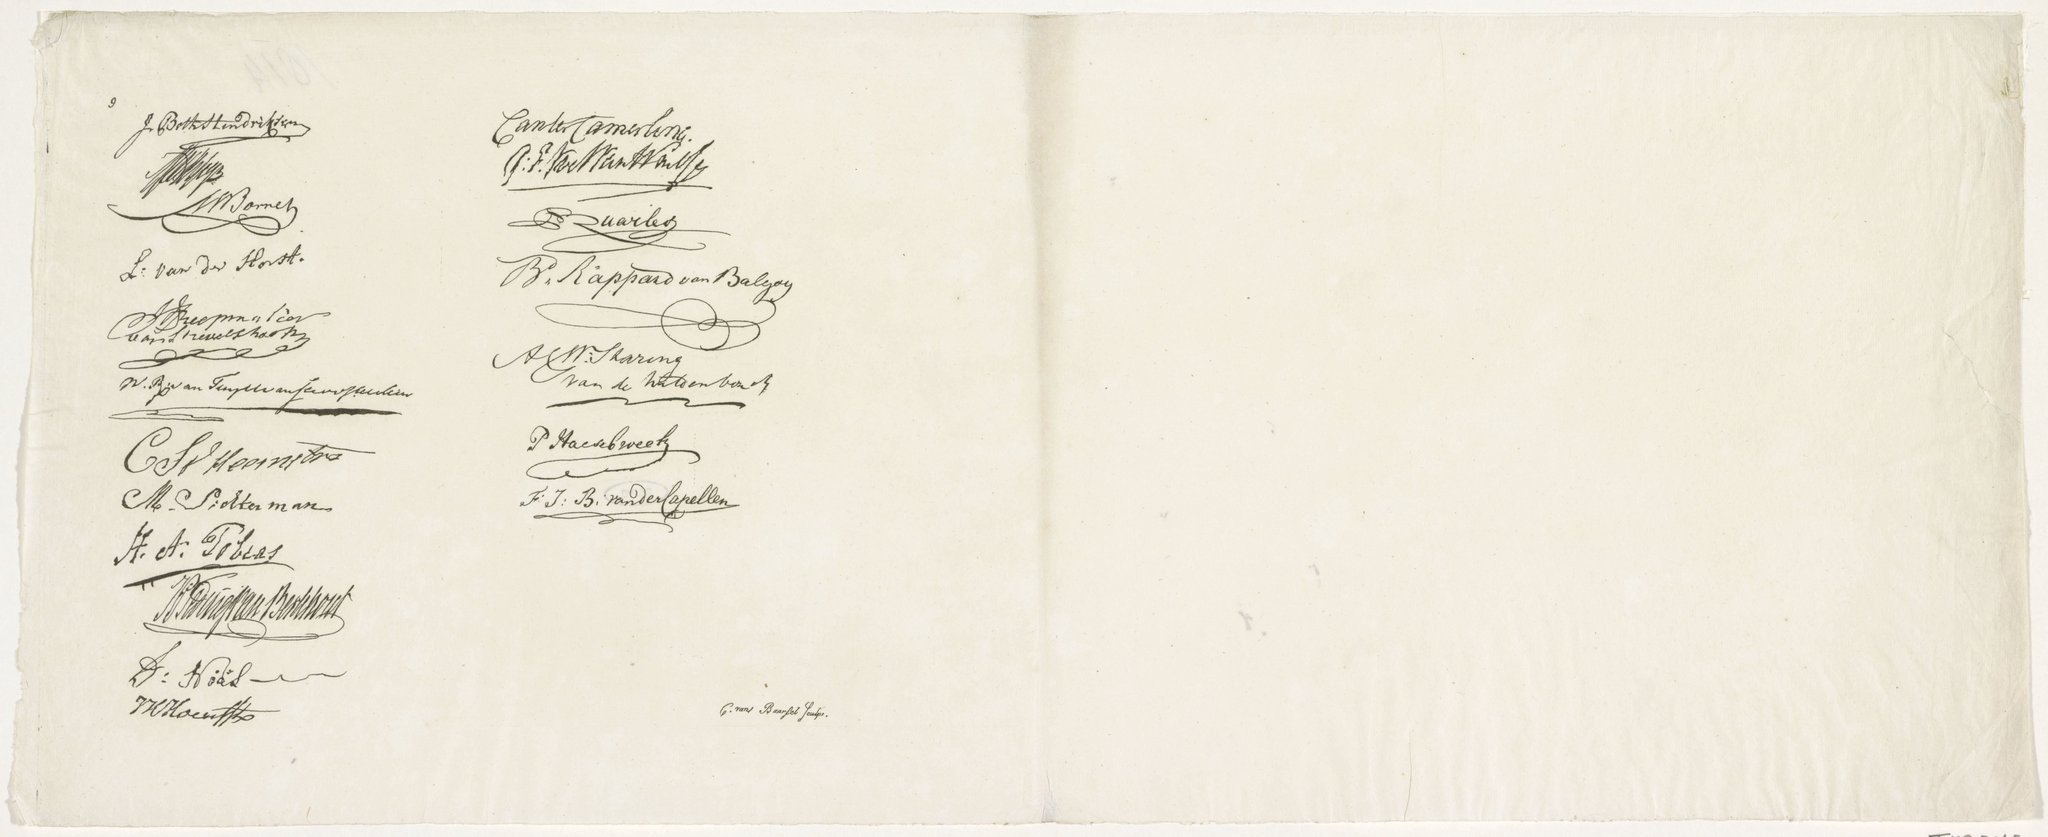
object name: print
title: Naamteekeningen der leden van de Vergadering der Aanzienlijken, ter goed- of afkeuring der Grondwet voor de Vereenigde Nederlanden. Gegraveerd naar de oorspronkelijke handteekeningen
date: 1814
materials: paper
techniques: etching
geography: the hague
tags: the hague, berlin, william i of the netherlands, handwriting, written text, amsterdam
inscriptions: collector's mark: Lugt 2228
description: Het laatste blad nr. 9 uit de serie van negen bladen met in facsimile de handtekeningen van de leden van de Vergadering der Aanzienlijken bijeen ter onderhandeling over de nieuwe grondwet, te Amsterdam op 29 maart 1814.